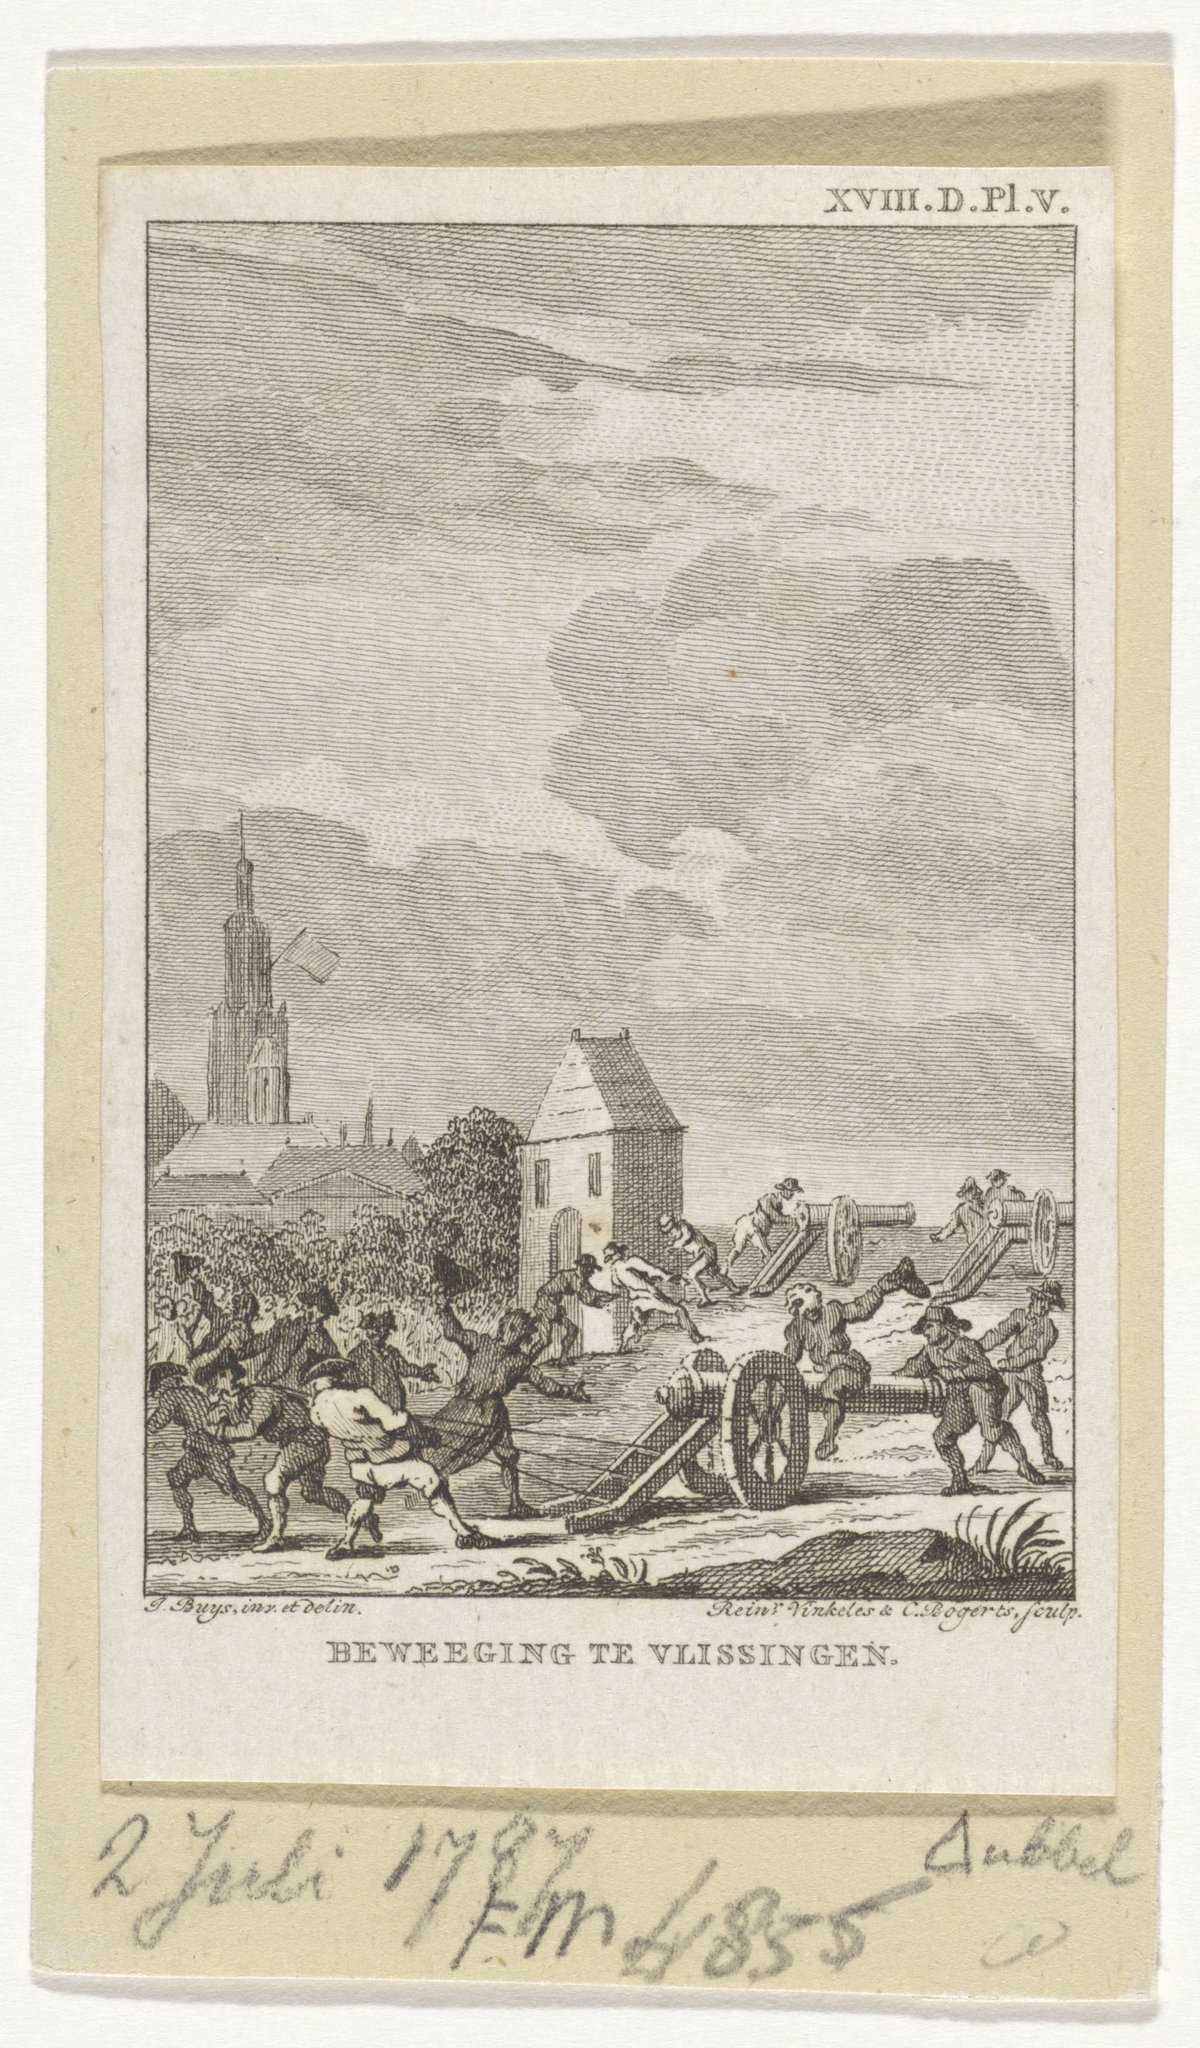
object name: print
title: Beweeging te Vlissingen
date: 1783-1795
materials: paper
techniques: etching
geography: amsterdam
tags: firearms: cannon, flushing, patriots (1780-1795)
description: Oranjegezinden verwijderen de kanonnen die door de Patriotse stadsregering op de stadswallen van Vlissingen zijn geplaatst, 2 juli 1787. Gemerkt bovenaan: XVIII.D.Pl.V.